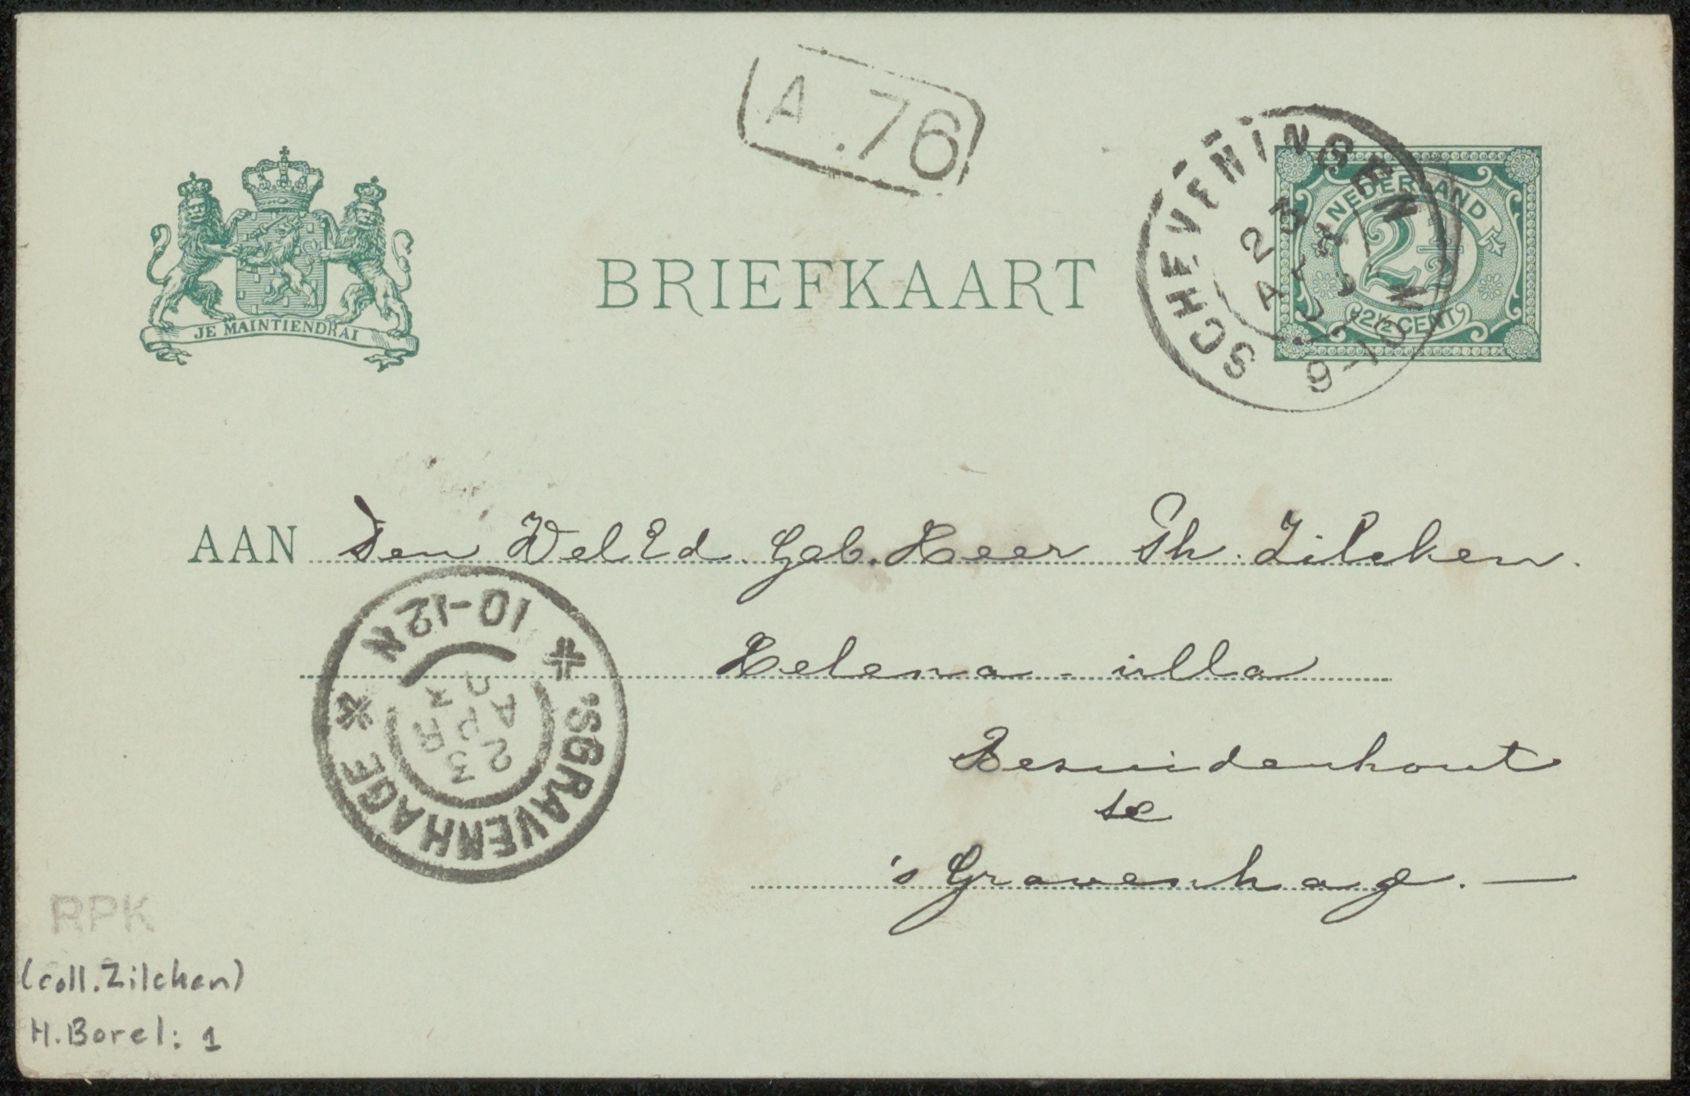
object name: postcard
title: Briefkaart aan Philip Zilcken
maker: henri borel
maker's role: journalist, schrijver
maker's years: 1869-1933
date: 1903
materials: cardboard, ink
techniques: pen, writing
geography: scheveningen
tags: rotterdam, painter, draughtsman, philip zilcken, china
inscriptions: collector's mark: ‘RPK’